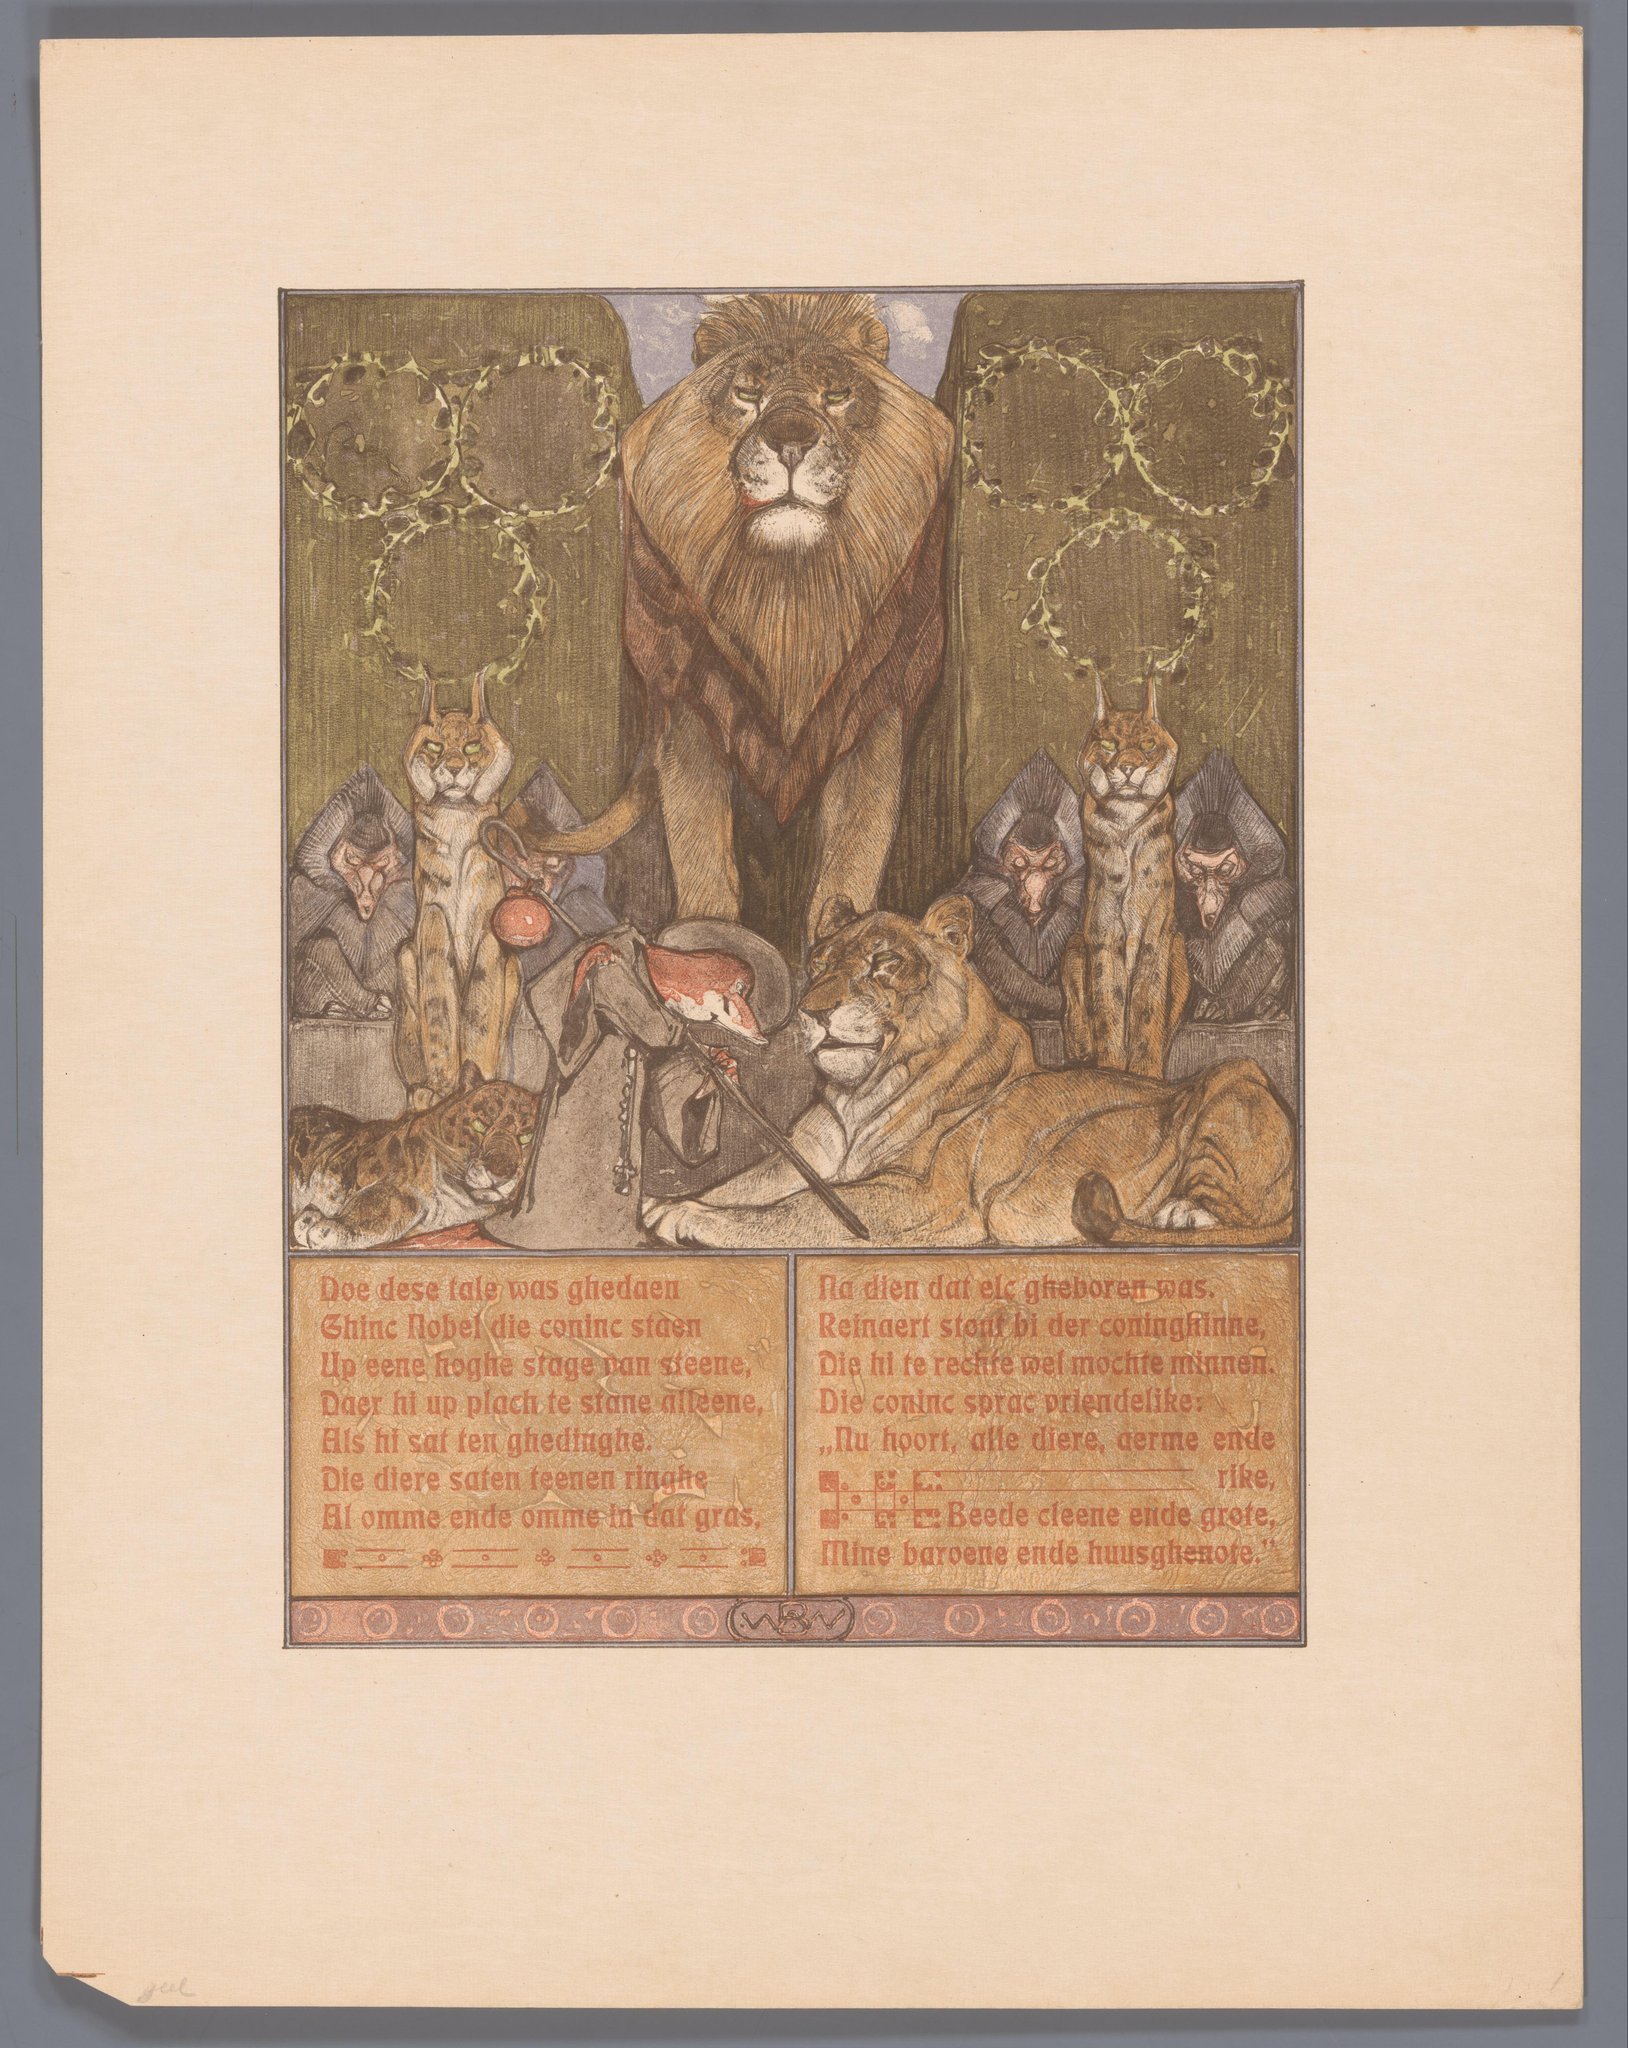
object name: book illustration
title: Vos in monnikspij (Reinaert) aan voeten van leeuw (Nobel) en leeuwin (Gentel), temidden van andere dieren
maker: bernard willem wierink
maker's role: draughtsman, print maker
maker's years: 1856-1939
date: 1910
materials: paper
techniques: lithograph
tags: fable of reynard the fox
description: Prent gebruikt in: Streuvels, Stijn (Frank Lateur). Reinaert de Vos naar verschillende uitgaven van het middeleeuwsche epos. Amsterdam: L.J. Veen, 1910.